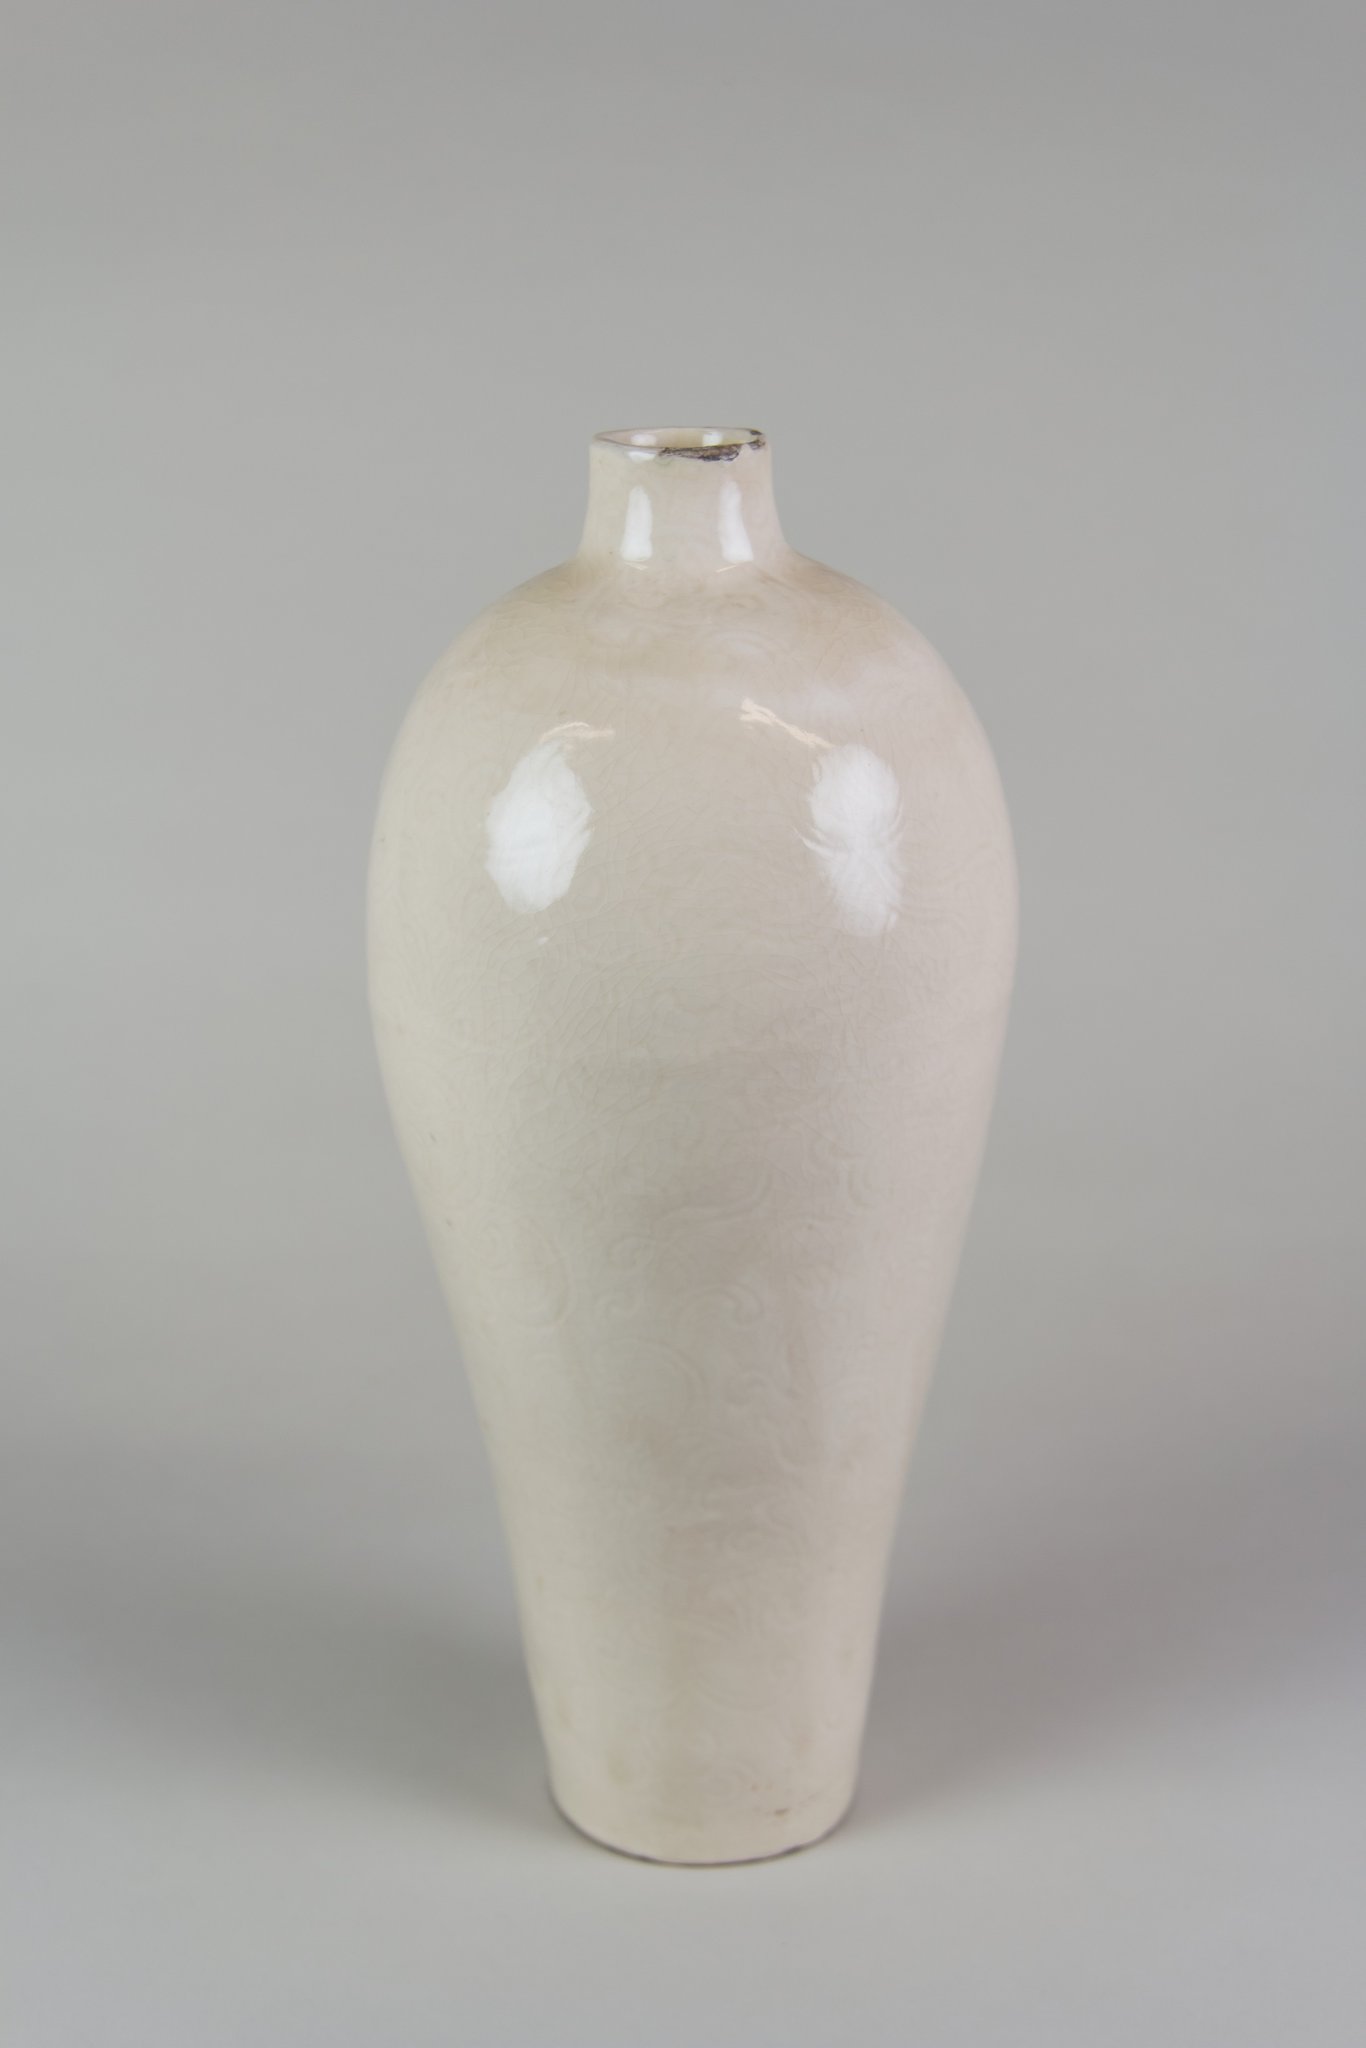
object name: vase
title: Meiping vase with floral scrolls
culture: chinese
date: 1701-1800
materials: glaze, porcelain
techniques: incising